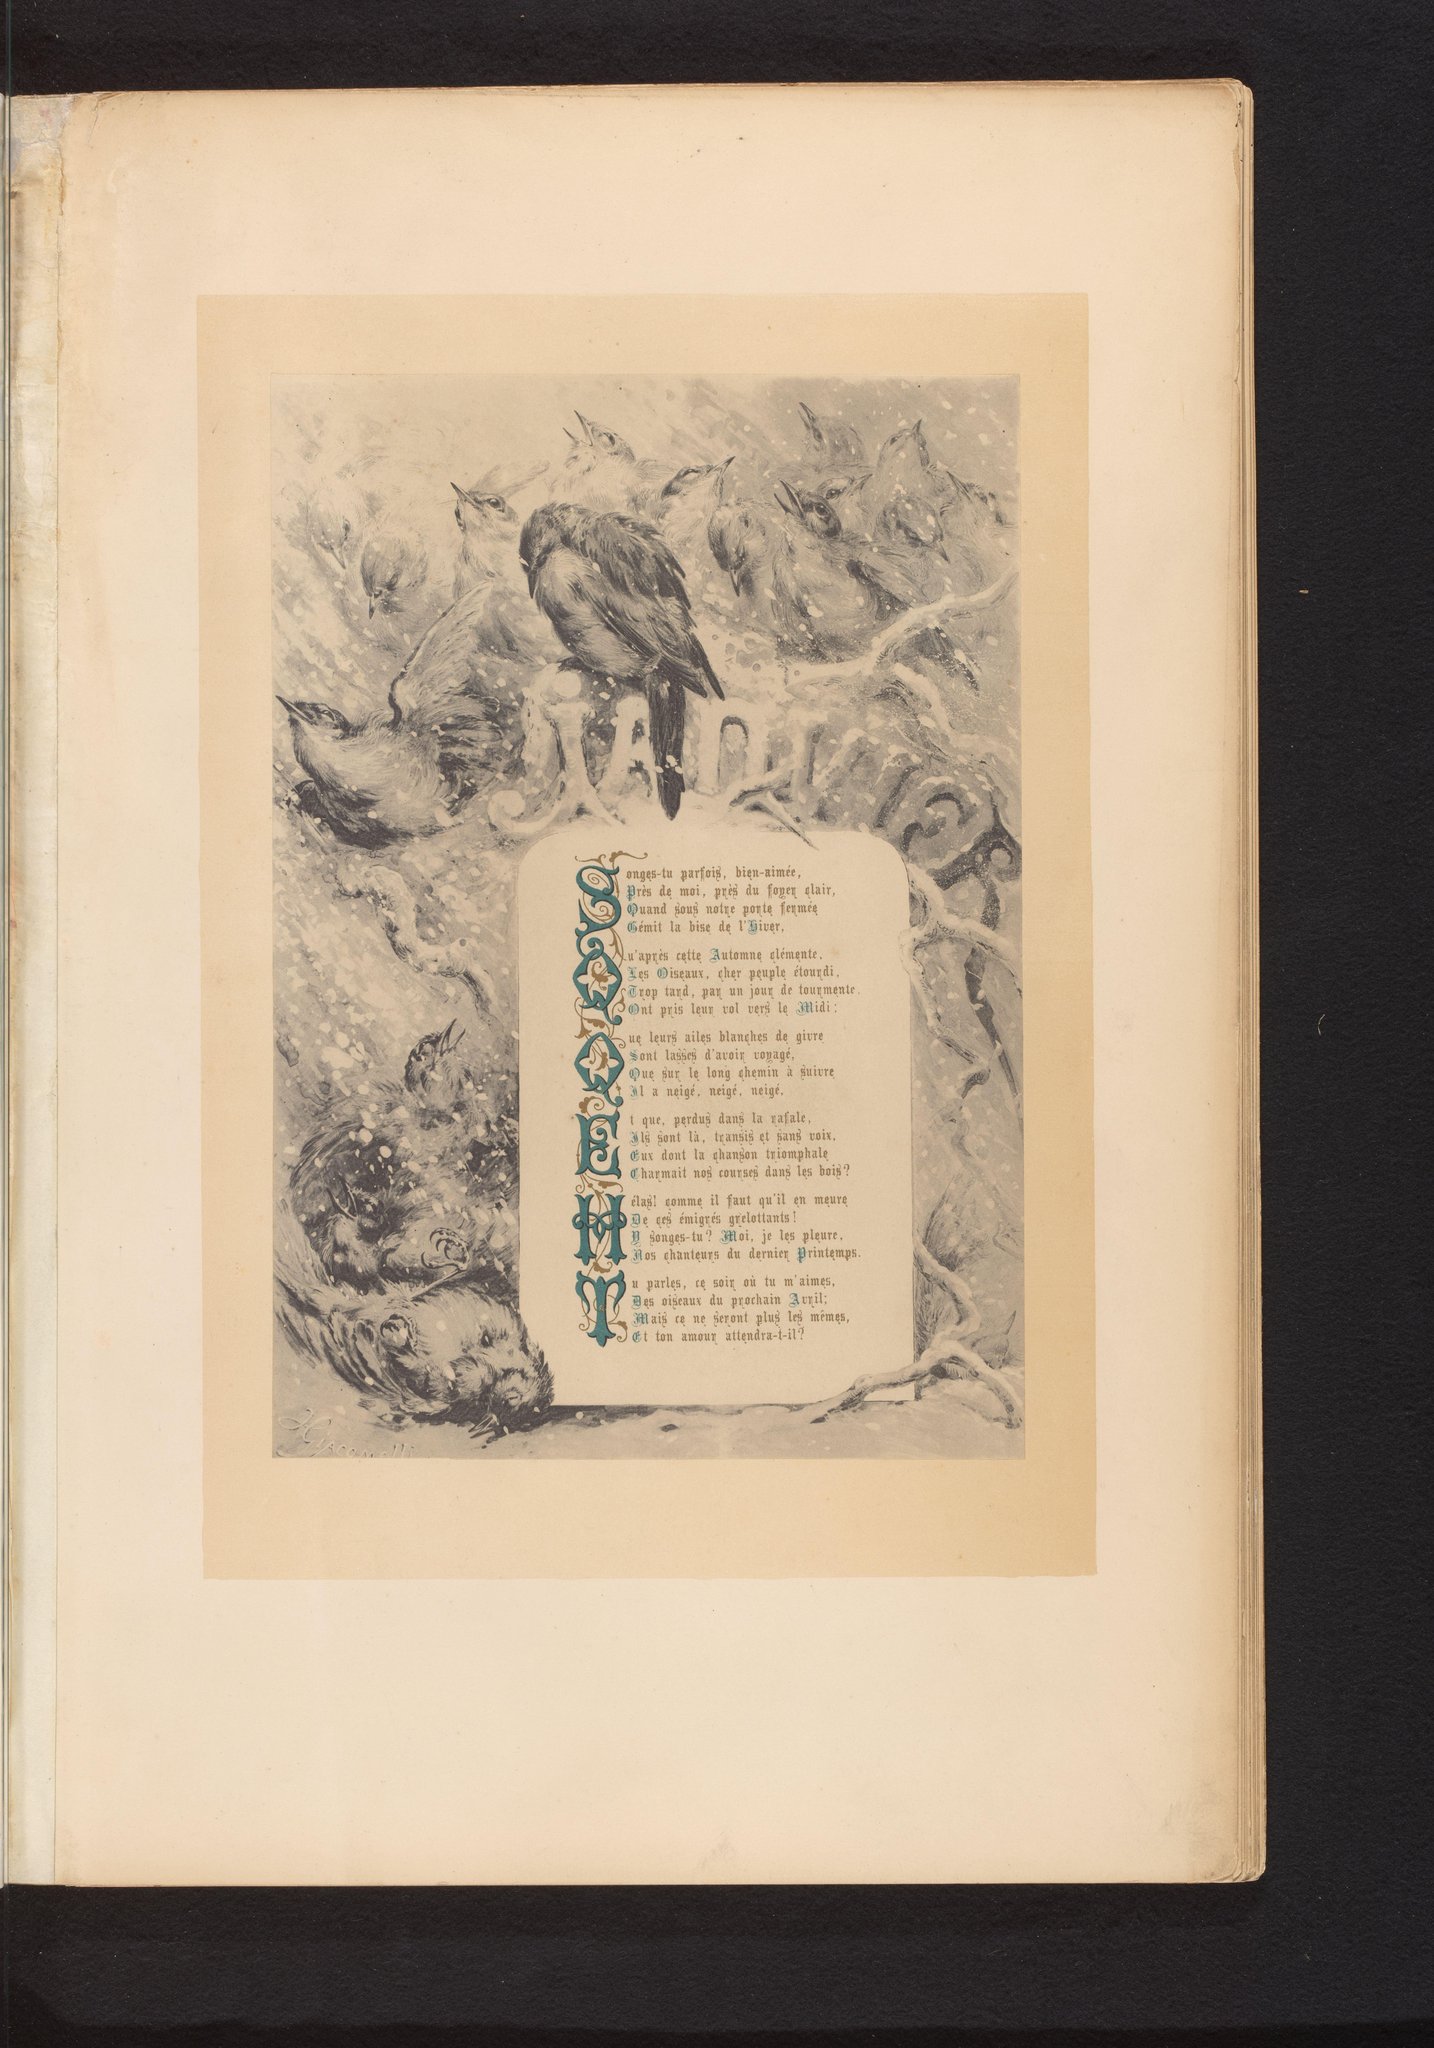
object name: photomechanical print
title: Reproductie van een prent van vogels in een sneeuwbui, met het gedicht Janvier van François Coppée, door Hector Giacomelli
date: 1871-1876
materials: paper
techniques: chromolithography, photograph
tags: birds, snowstorm, january ~ other concepts